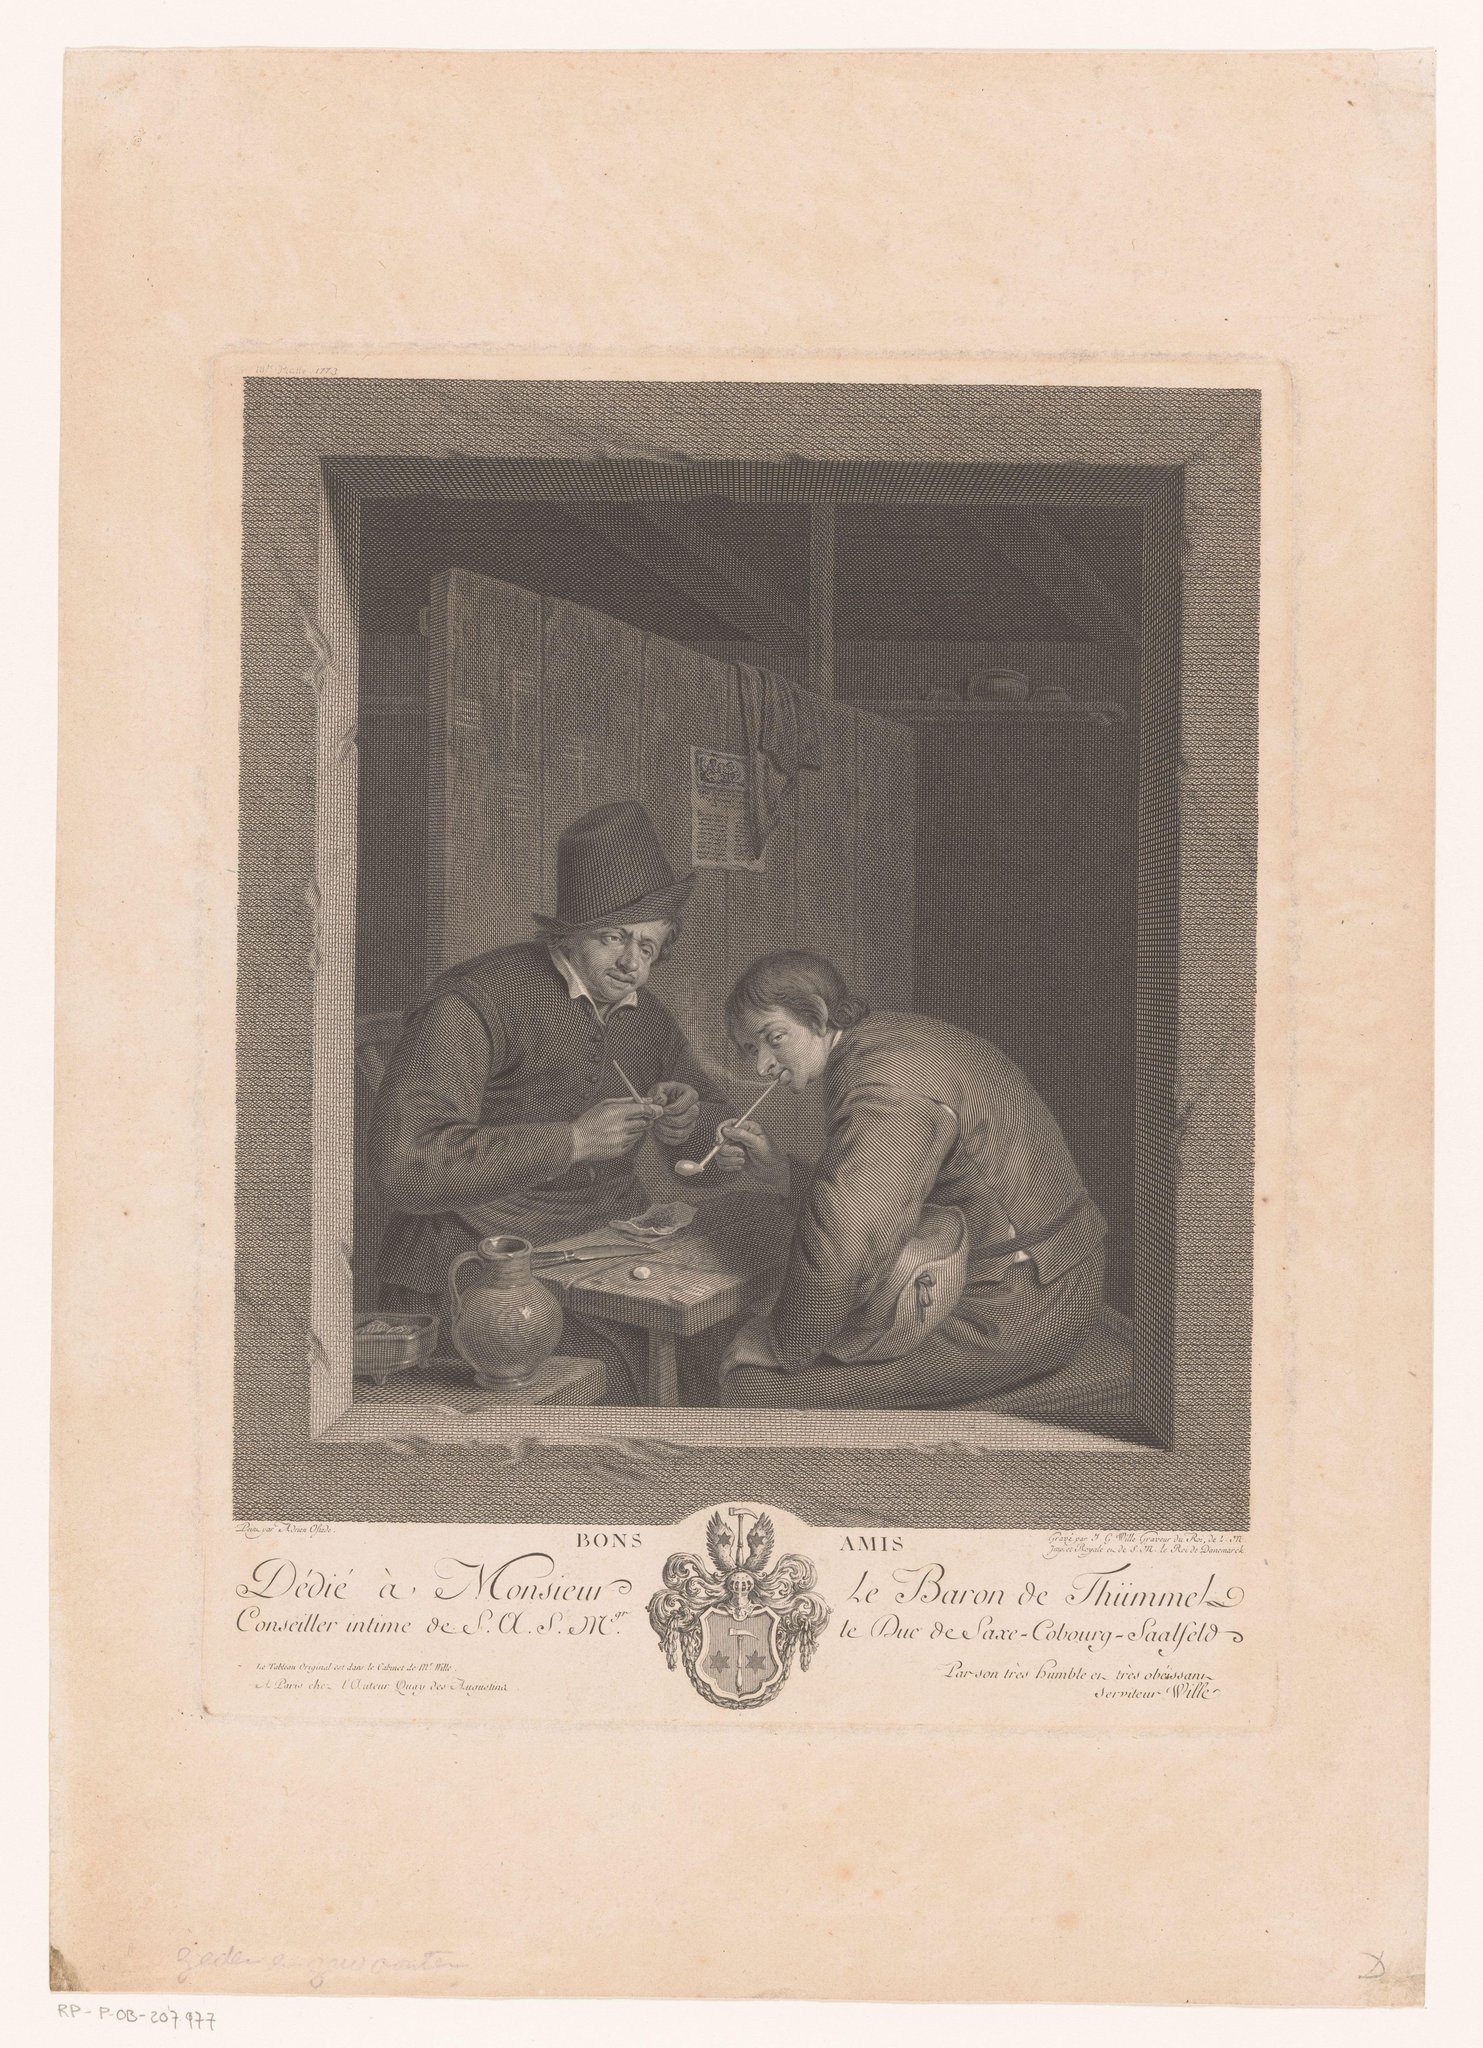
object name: print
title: Twee pijprokende mannen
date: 1773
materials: paper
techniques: engraving, etching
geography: paris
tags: pipe ~ tobacco, interior of the house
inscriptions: collector's mark: Lugt 2228, collector's mark: Lugt 240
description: Deze prent maakt deel uit van een serie van onbekende omvang naar Nederlandse en Duitse schilderijen. Op sommige prenten staat linksboven aangegeven welk nummer in de serie het betreft.